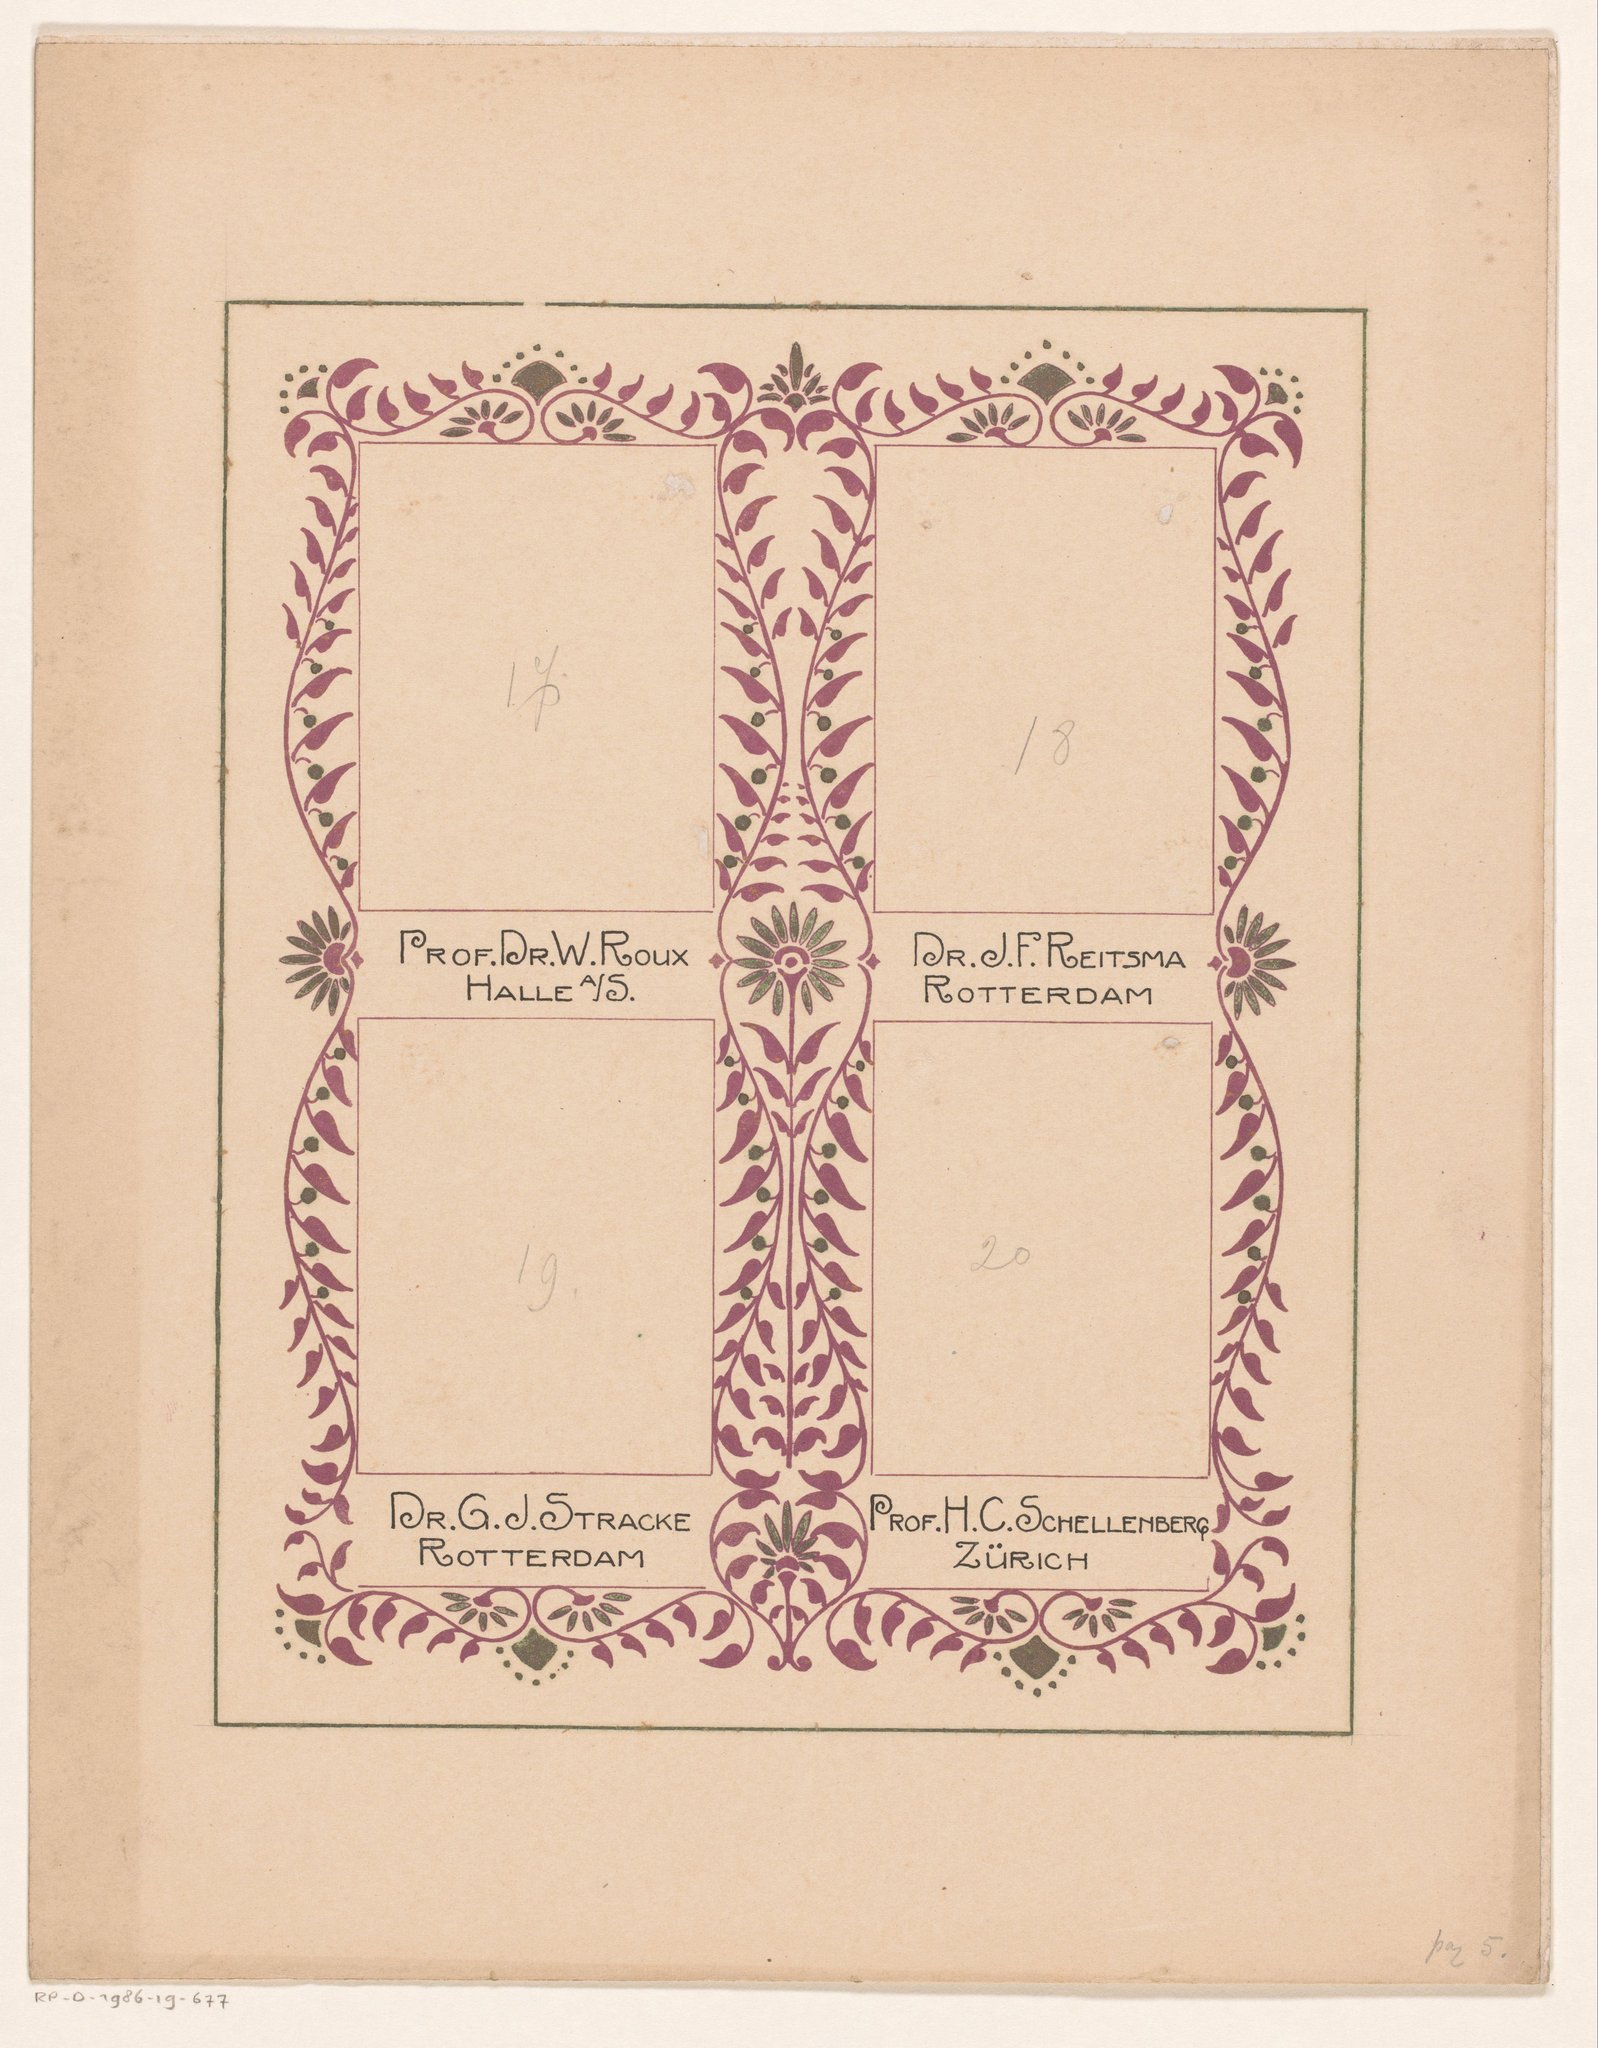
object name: drawing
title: Albumblad voor een album voor Prof. Hugo de Vries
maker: reinier willem petrus de vries (1874-1953)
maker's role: draughtsman, print maker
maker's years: 1874-1953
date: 1918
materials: paint, ink, paper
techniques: brush, lithograph, pen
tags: haarlem, hugo de vries, flowers ~ ornament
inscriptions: annotation: ‘pag 5.’, collector's mark: ‘R:MVS.’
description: Rechthoekig kader met bloem- en bladornamenten met daarin vier vakken voor portretten met onder elk vak de naam van de geportretteerde.